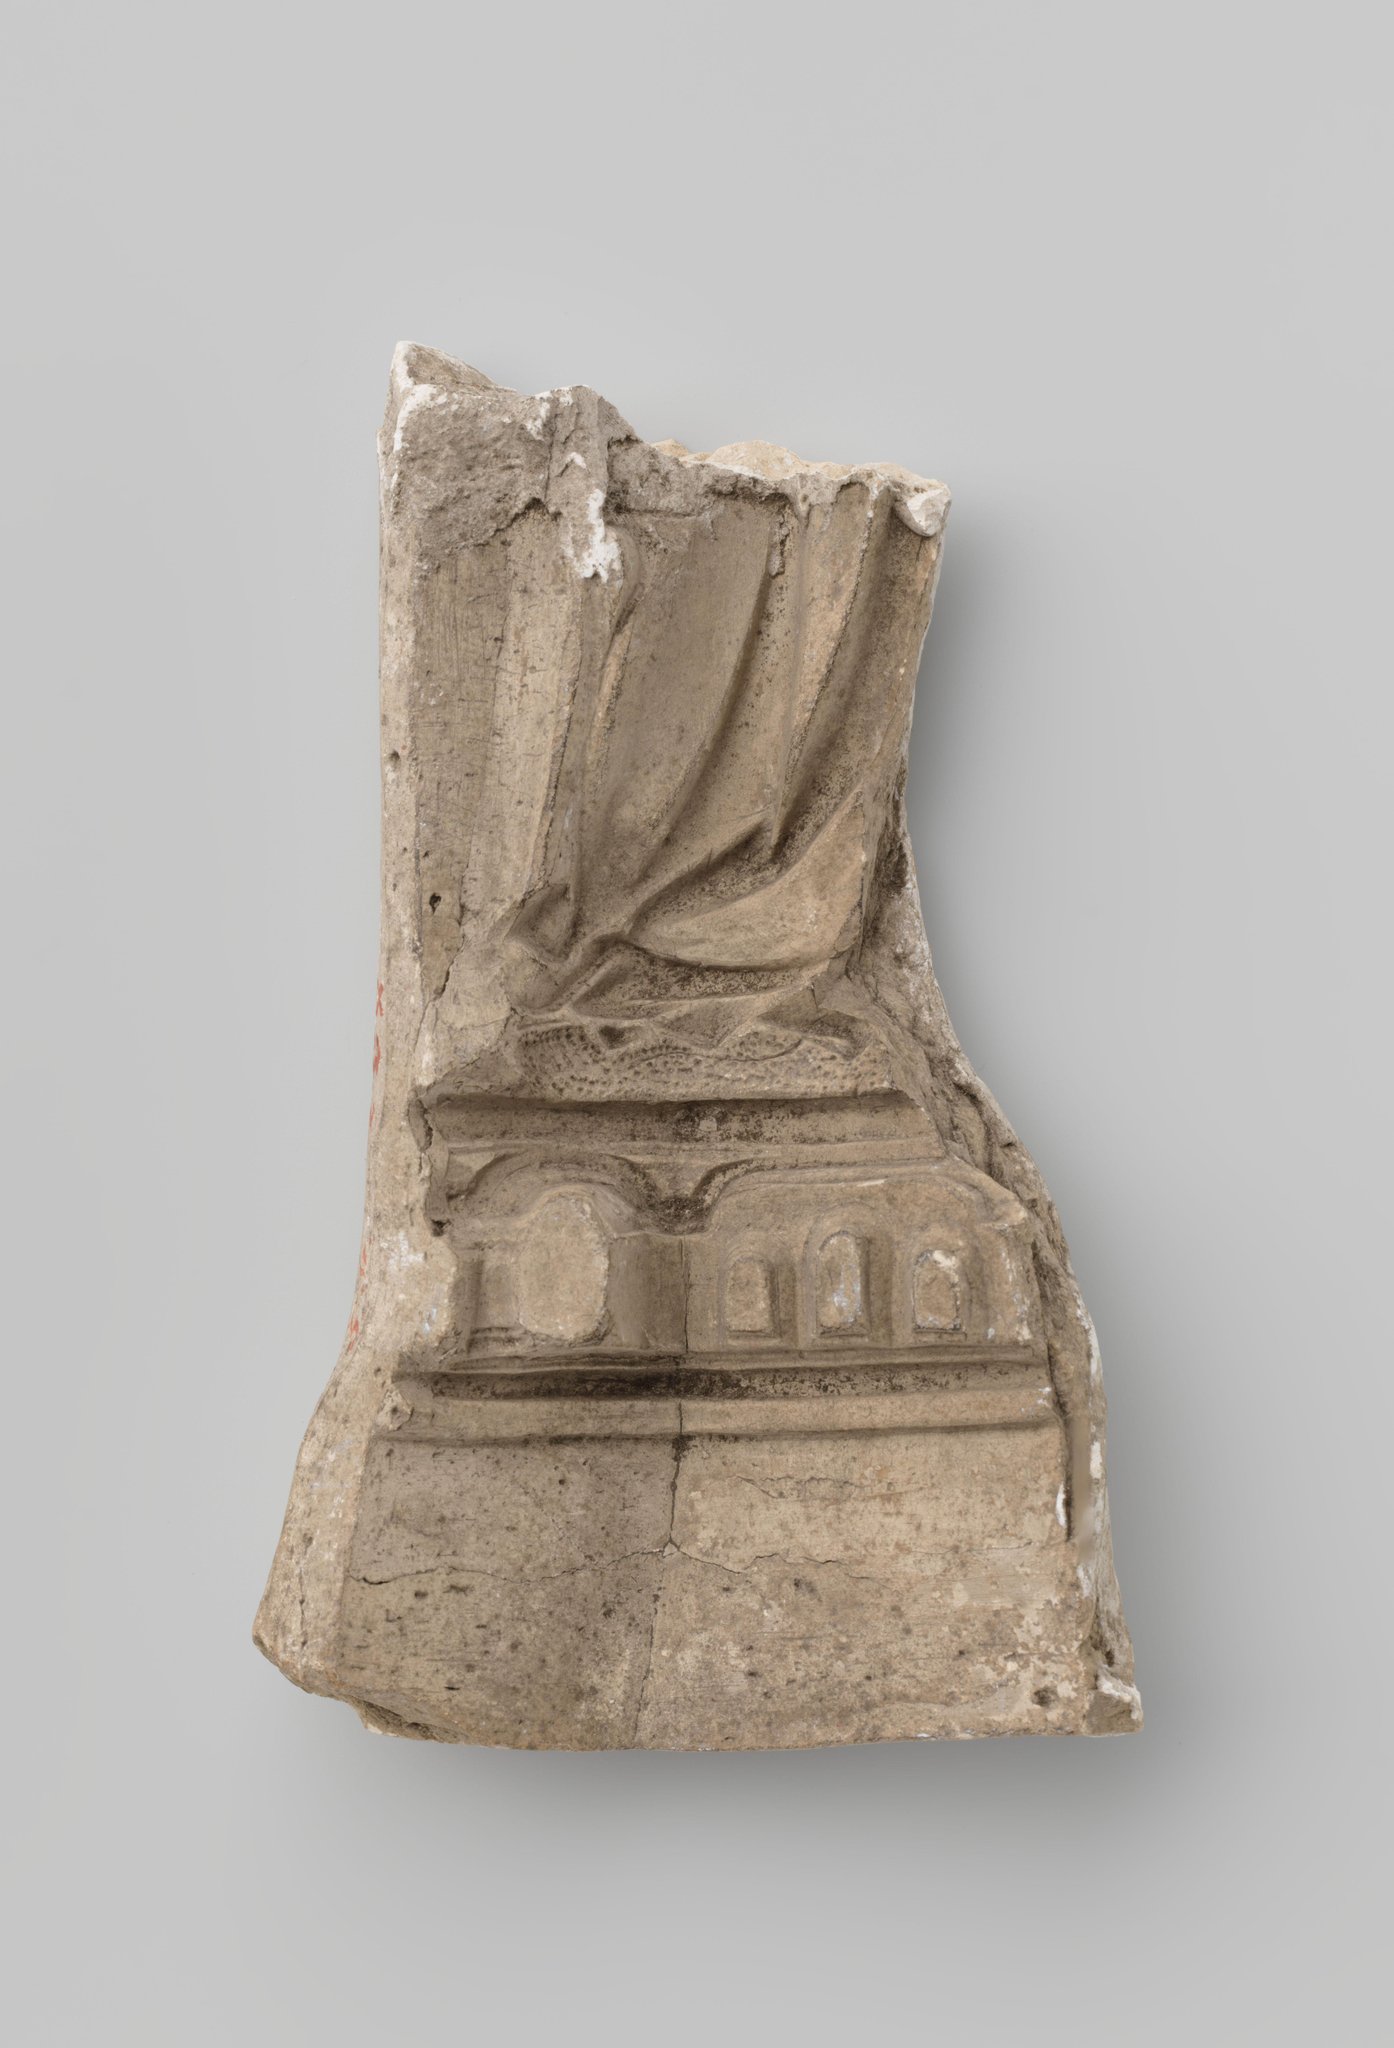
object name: sculpture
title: Front Mould of a Virgin and Child (?), Fragment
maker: Anonymous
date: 1425-1450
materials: clay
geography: utrecht